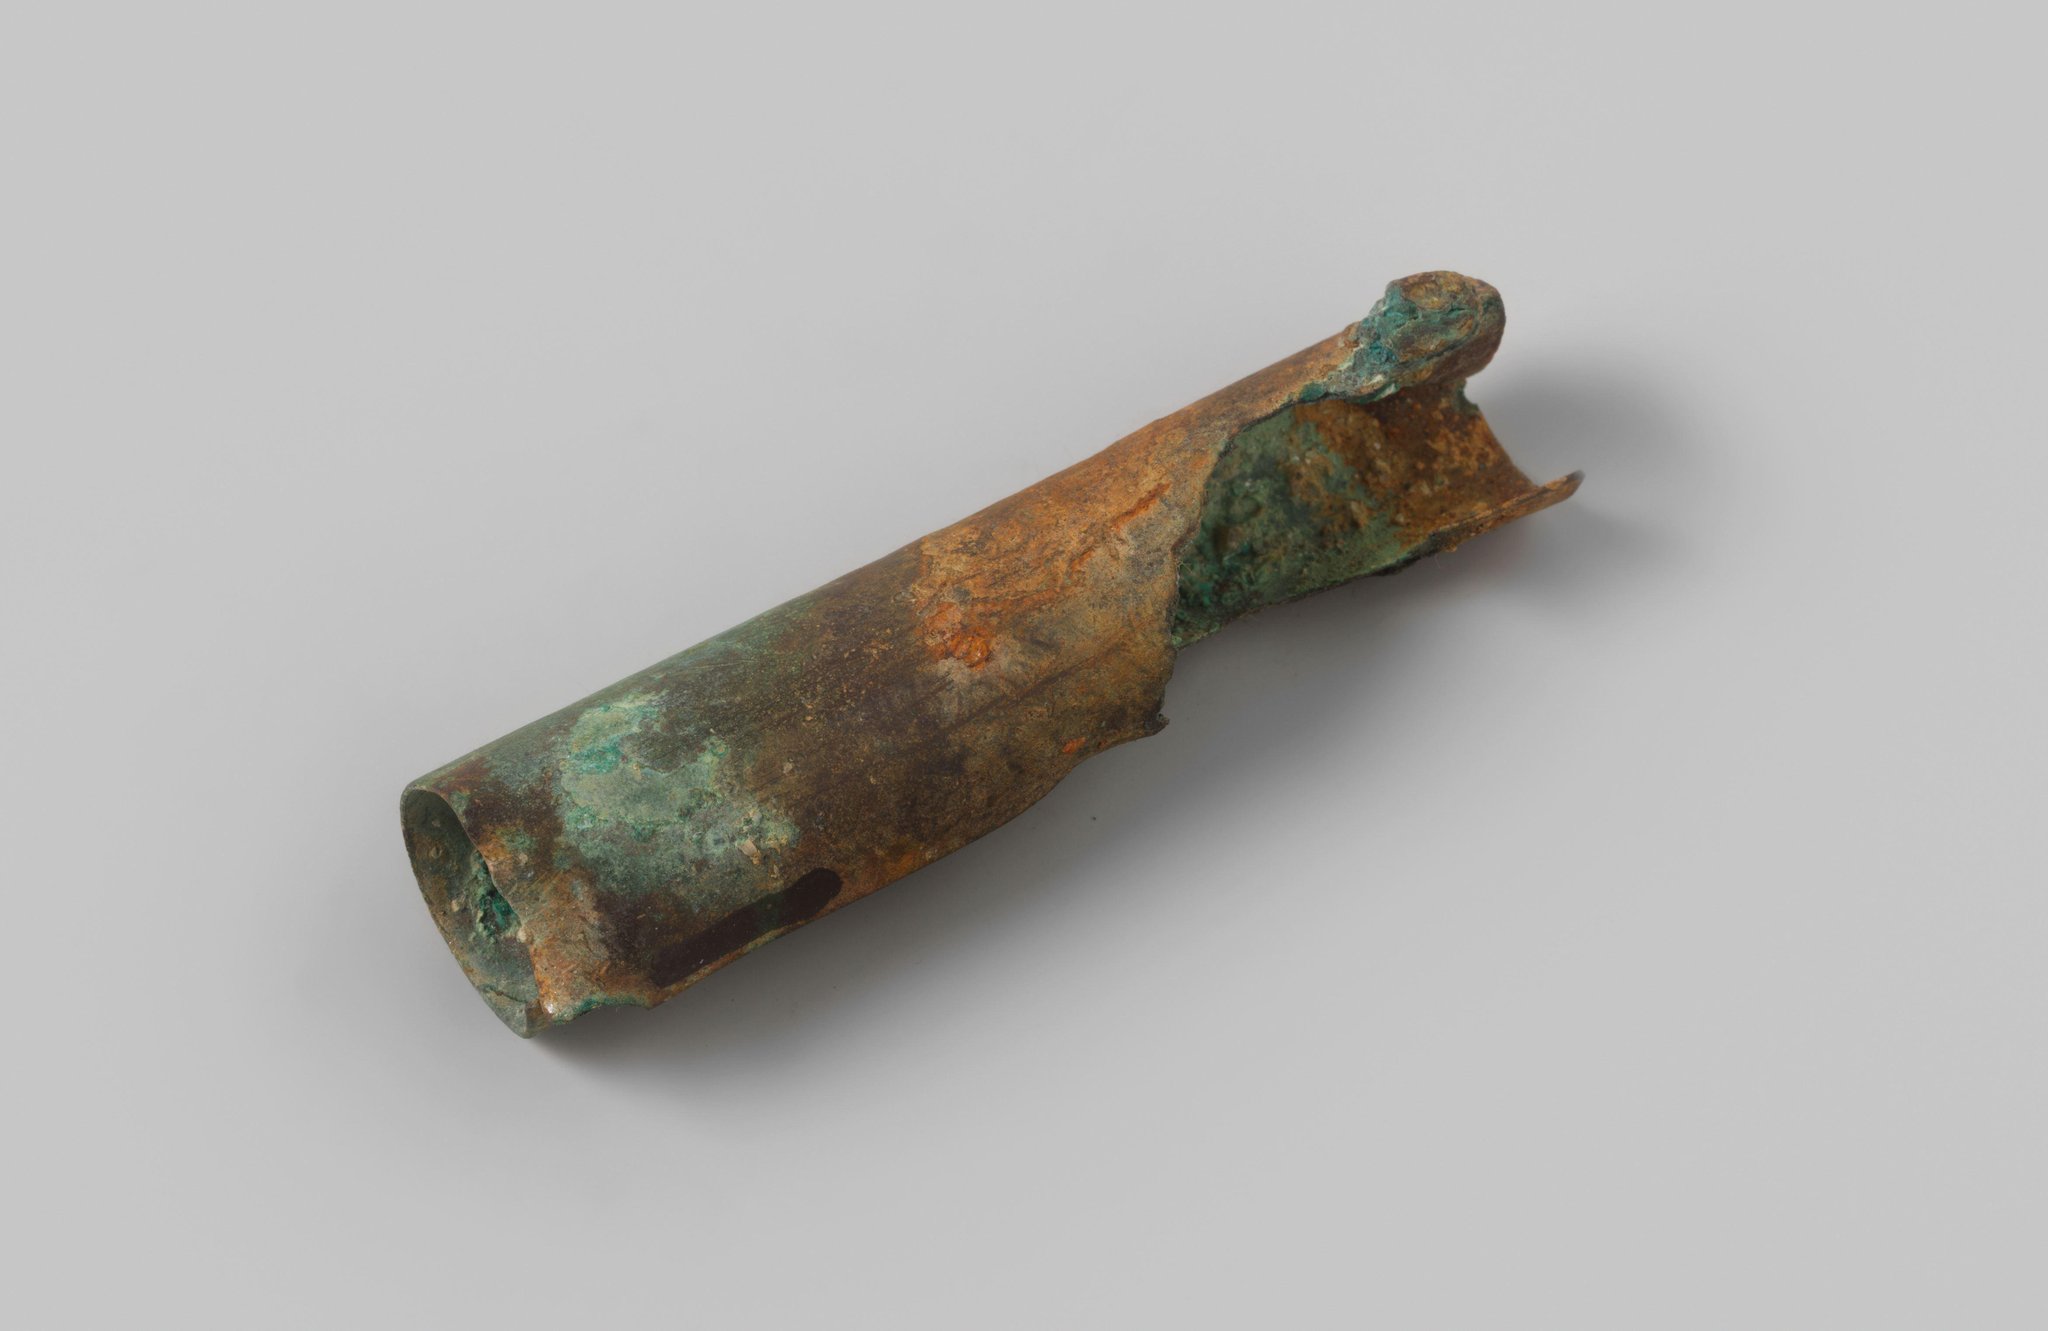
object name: cartridge shell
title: Patroonhuls uit het wrak van de Oost-Indiëvaarder Hollandia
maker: Anonymous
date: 1700-1743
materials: copper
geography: netherlands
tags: verenigde oostindische compagnie, hollandia (schip), annet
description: Cartridge case, tube; eroded, id. NG 1979-205H549.